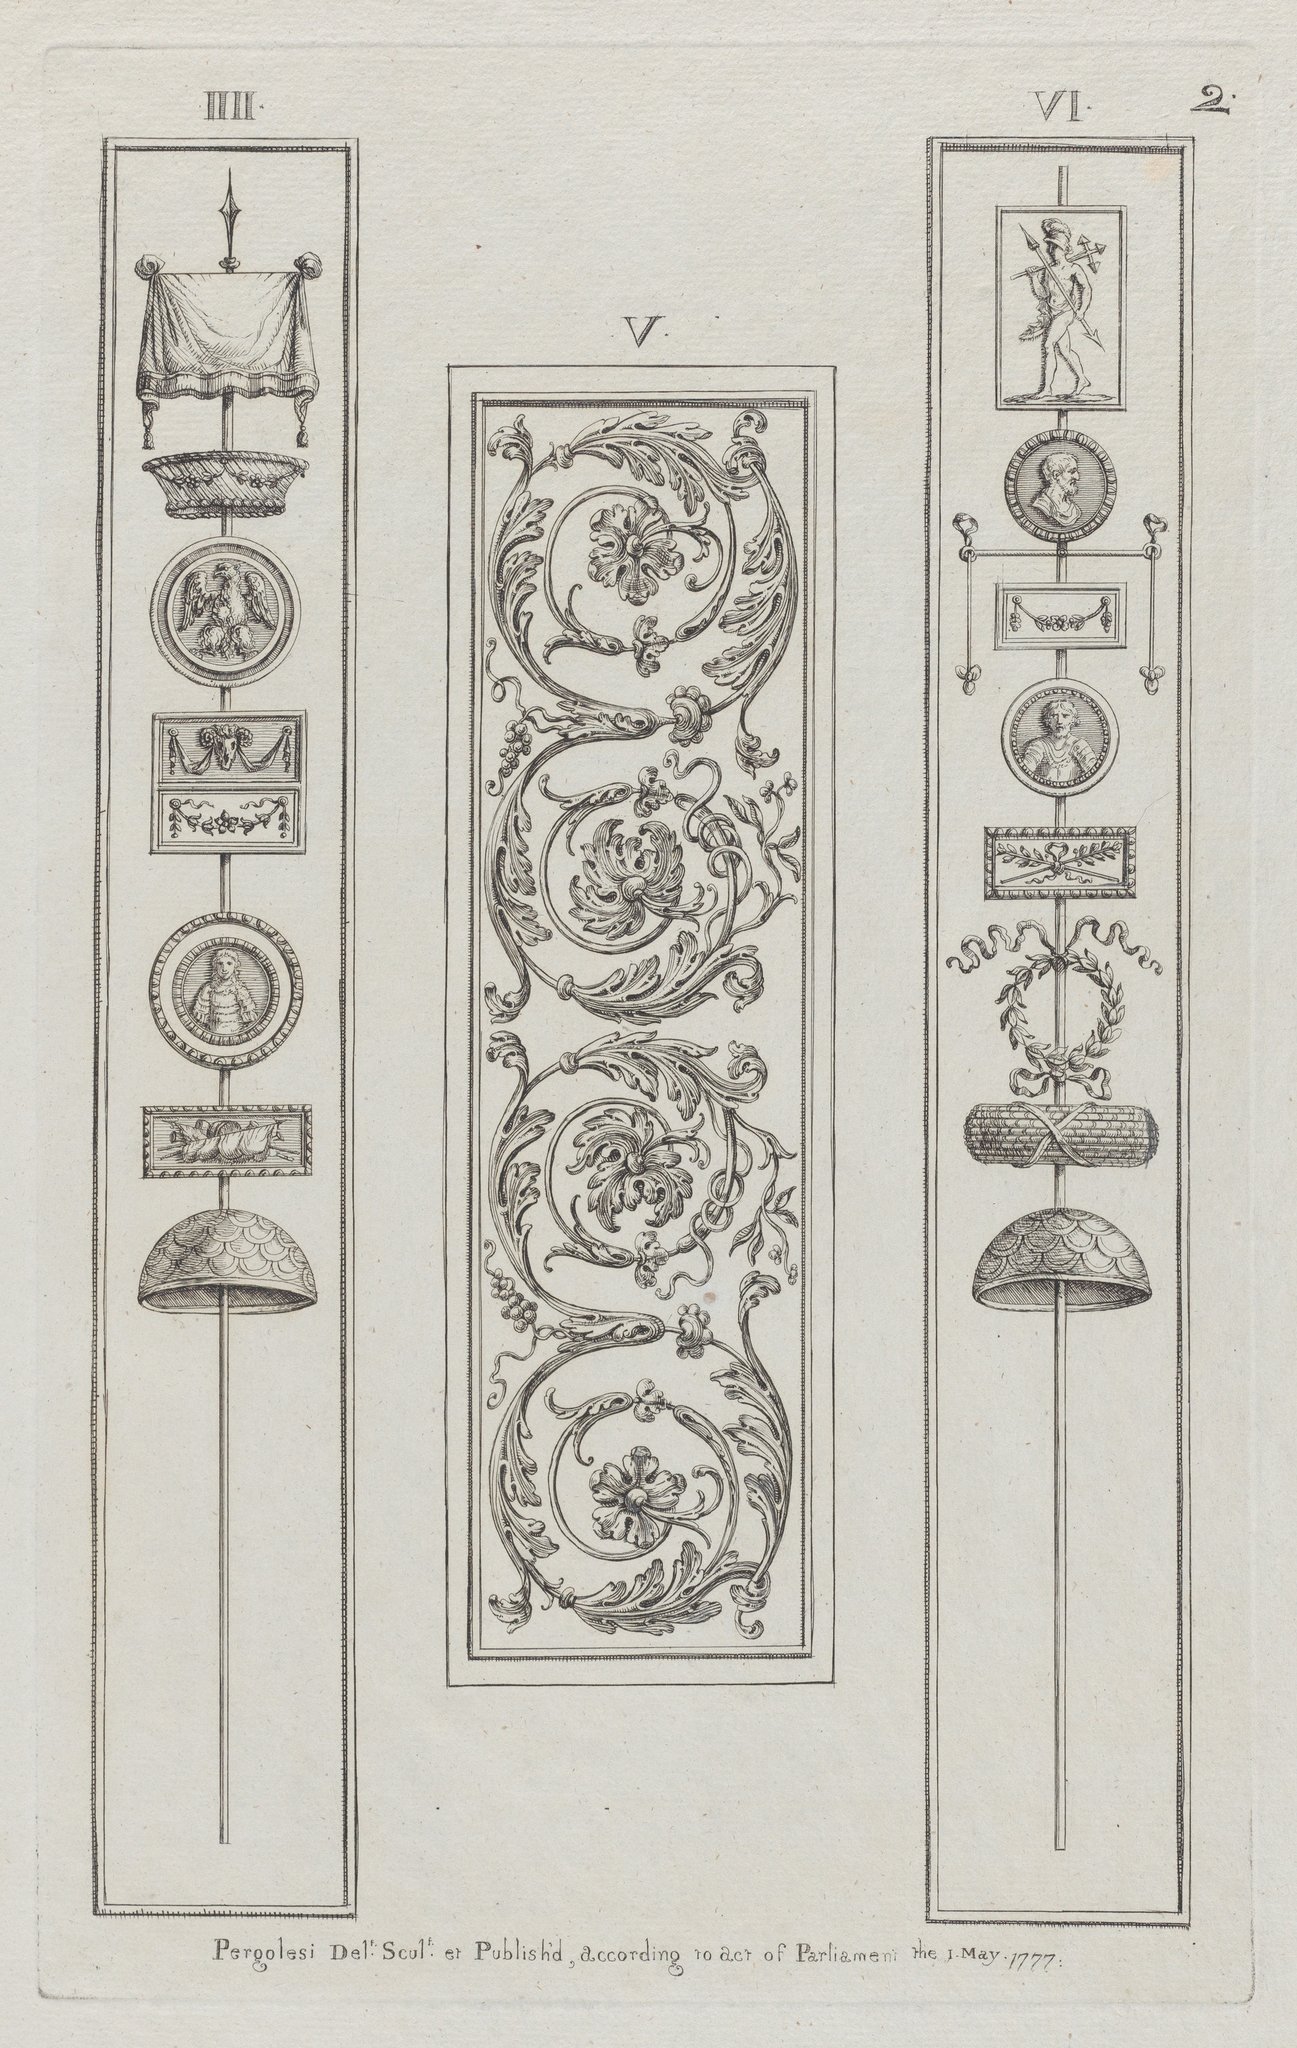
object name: print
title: Panels of Ornament, nos. IIII–VI, plate 2 from "Designs for Various Ornaments"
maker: michelangelo pergolesi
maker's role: artist and publisher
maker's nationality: italian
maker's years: 1760-1801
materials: ink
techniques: etching, printing